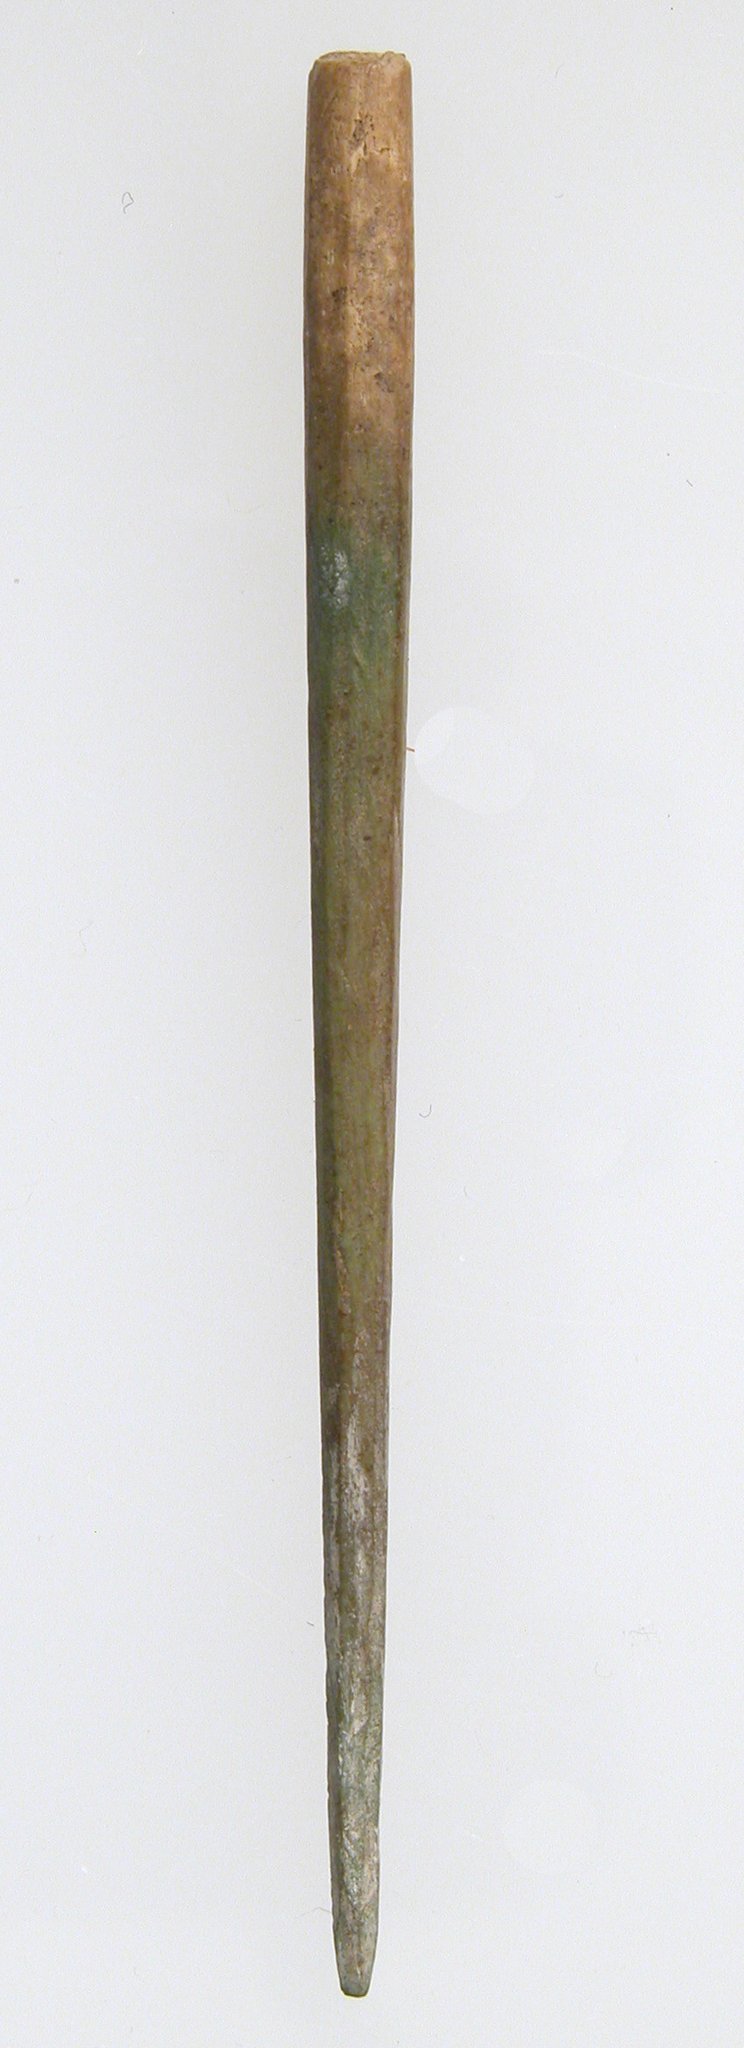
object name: hairpin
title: Hairpin Part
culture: roman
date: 1-400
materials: bone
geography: northern france